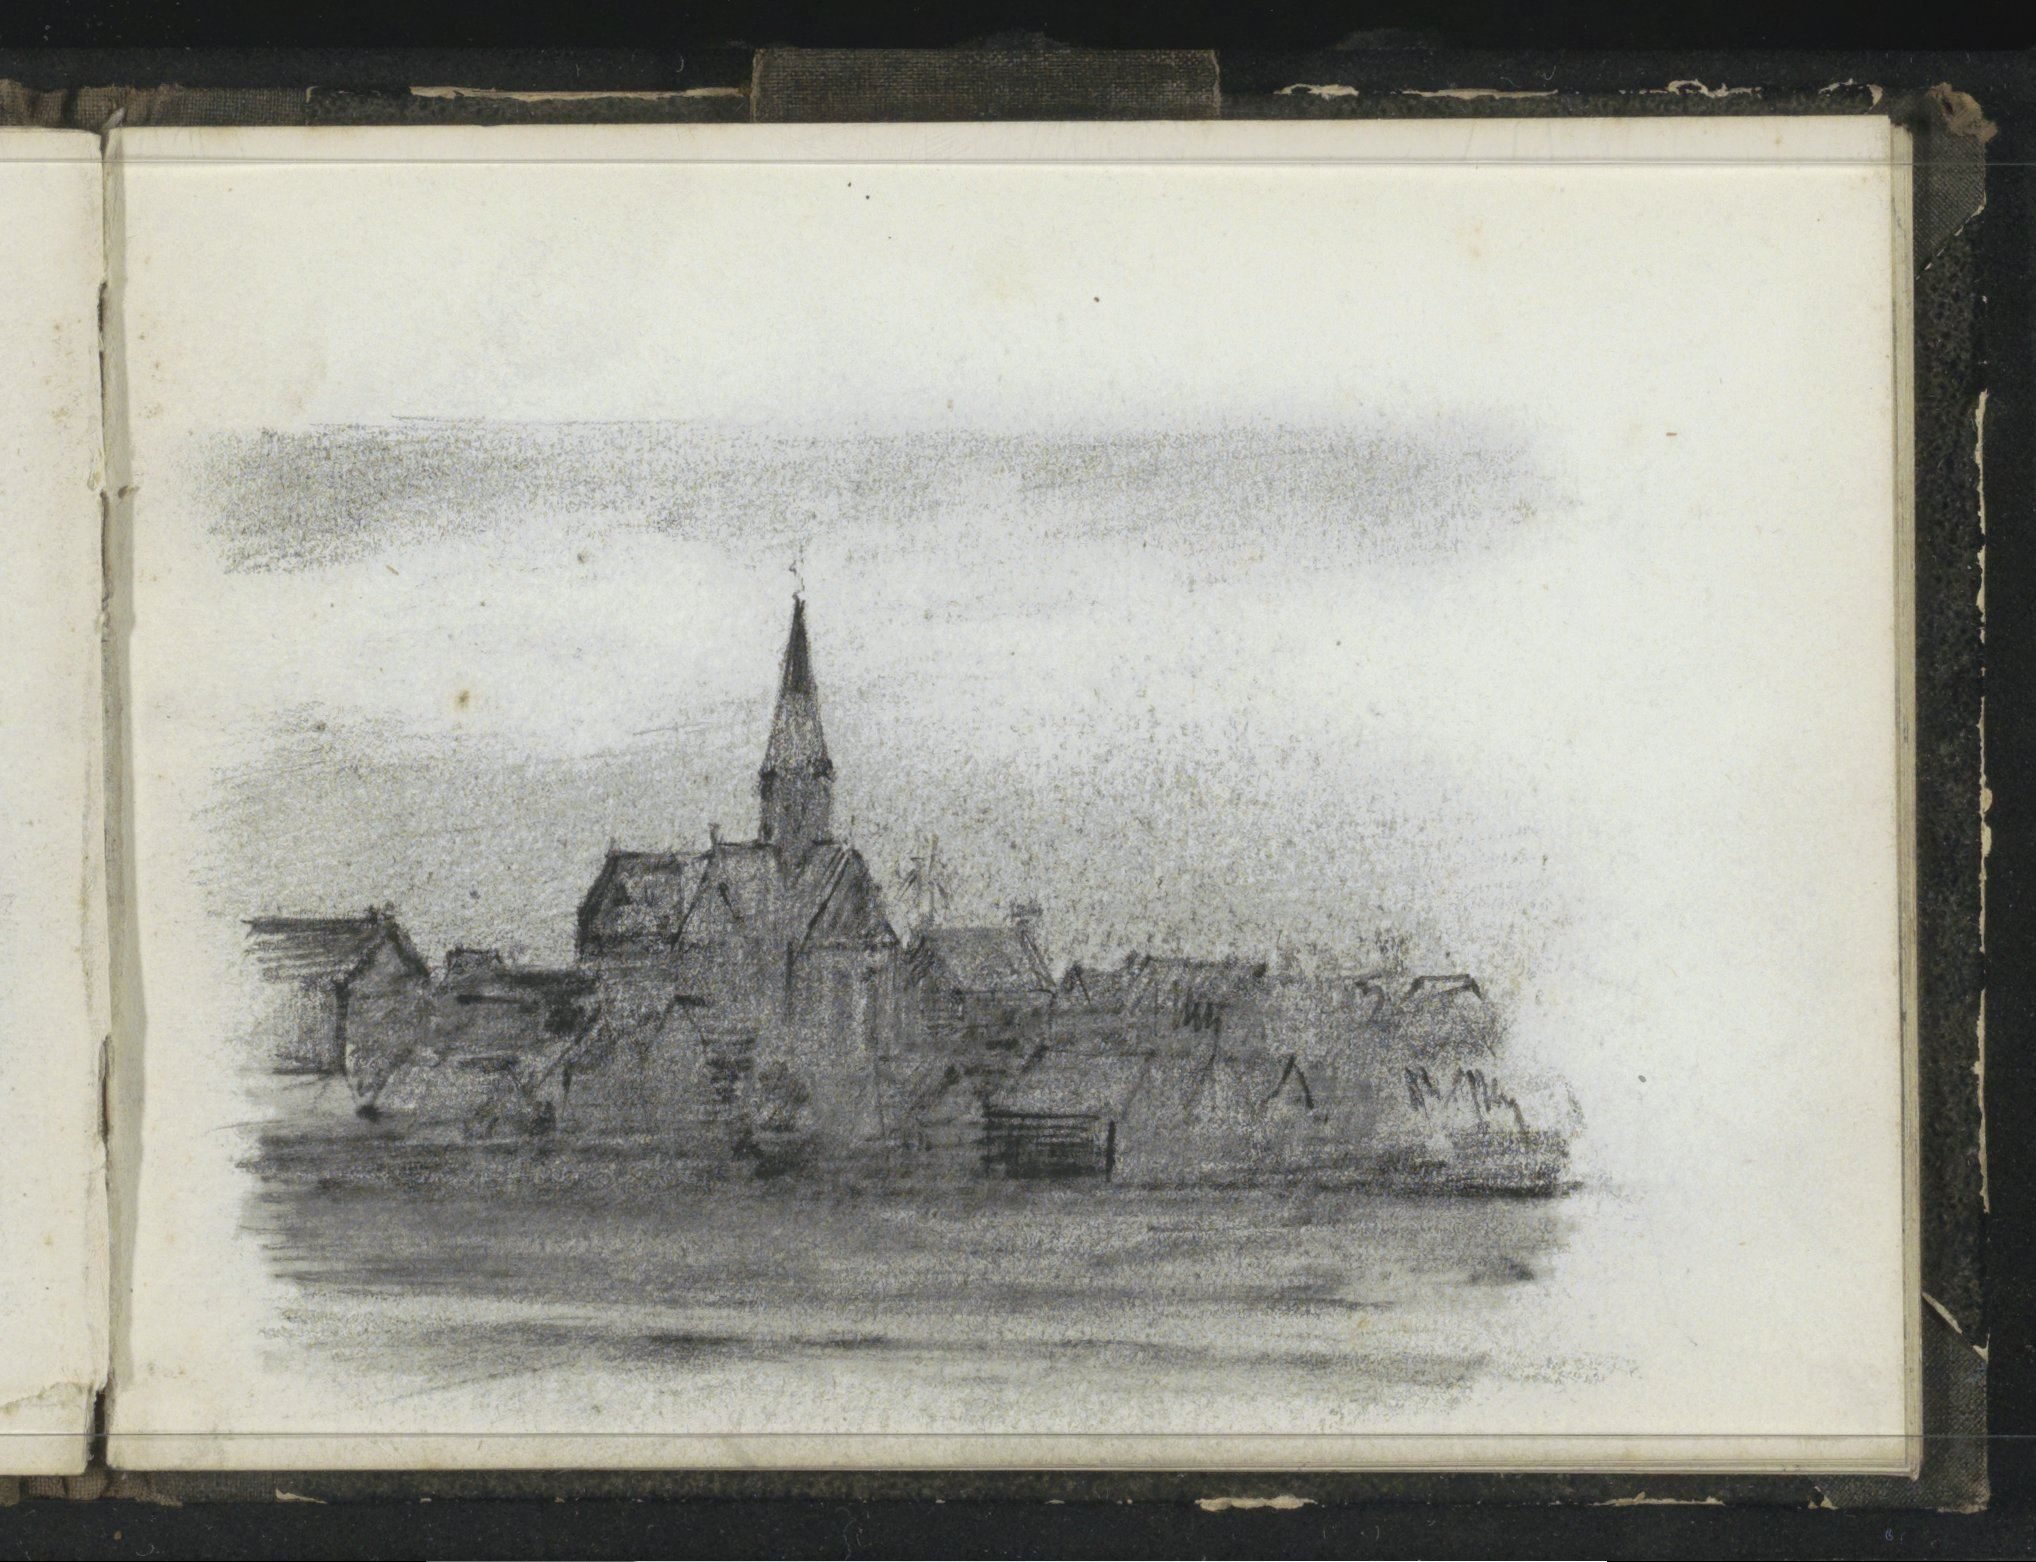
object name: sketchbook leaf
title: Dorpsgezicht met kerk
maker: theo hanrath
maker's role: draughtsman, painter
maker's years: 1853-1883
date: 1879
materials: paper, pencil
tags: prospect of village, silhouette of village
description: Blad 14 recto uit een schetsboek met 27 bladen.